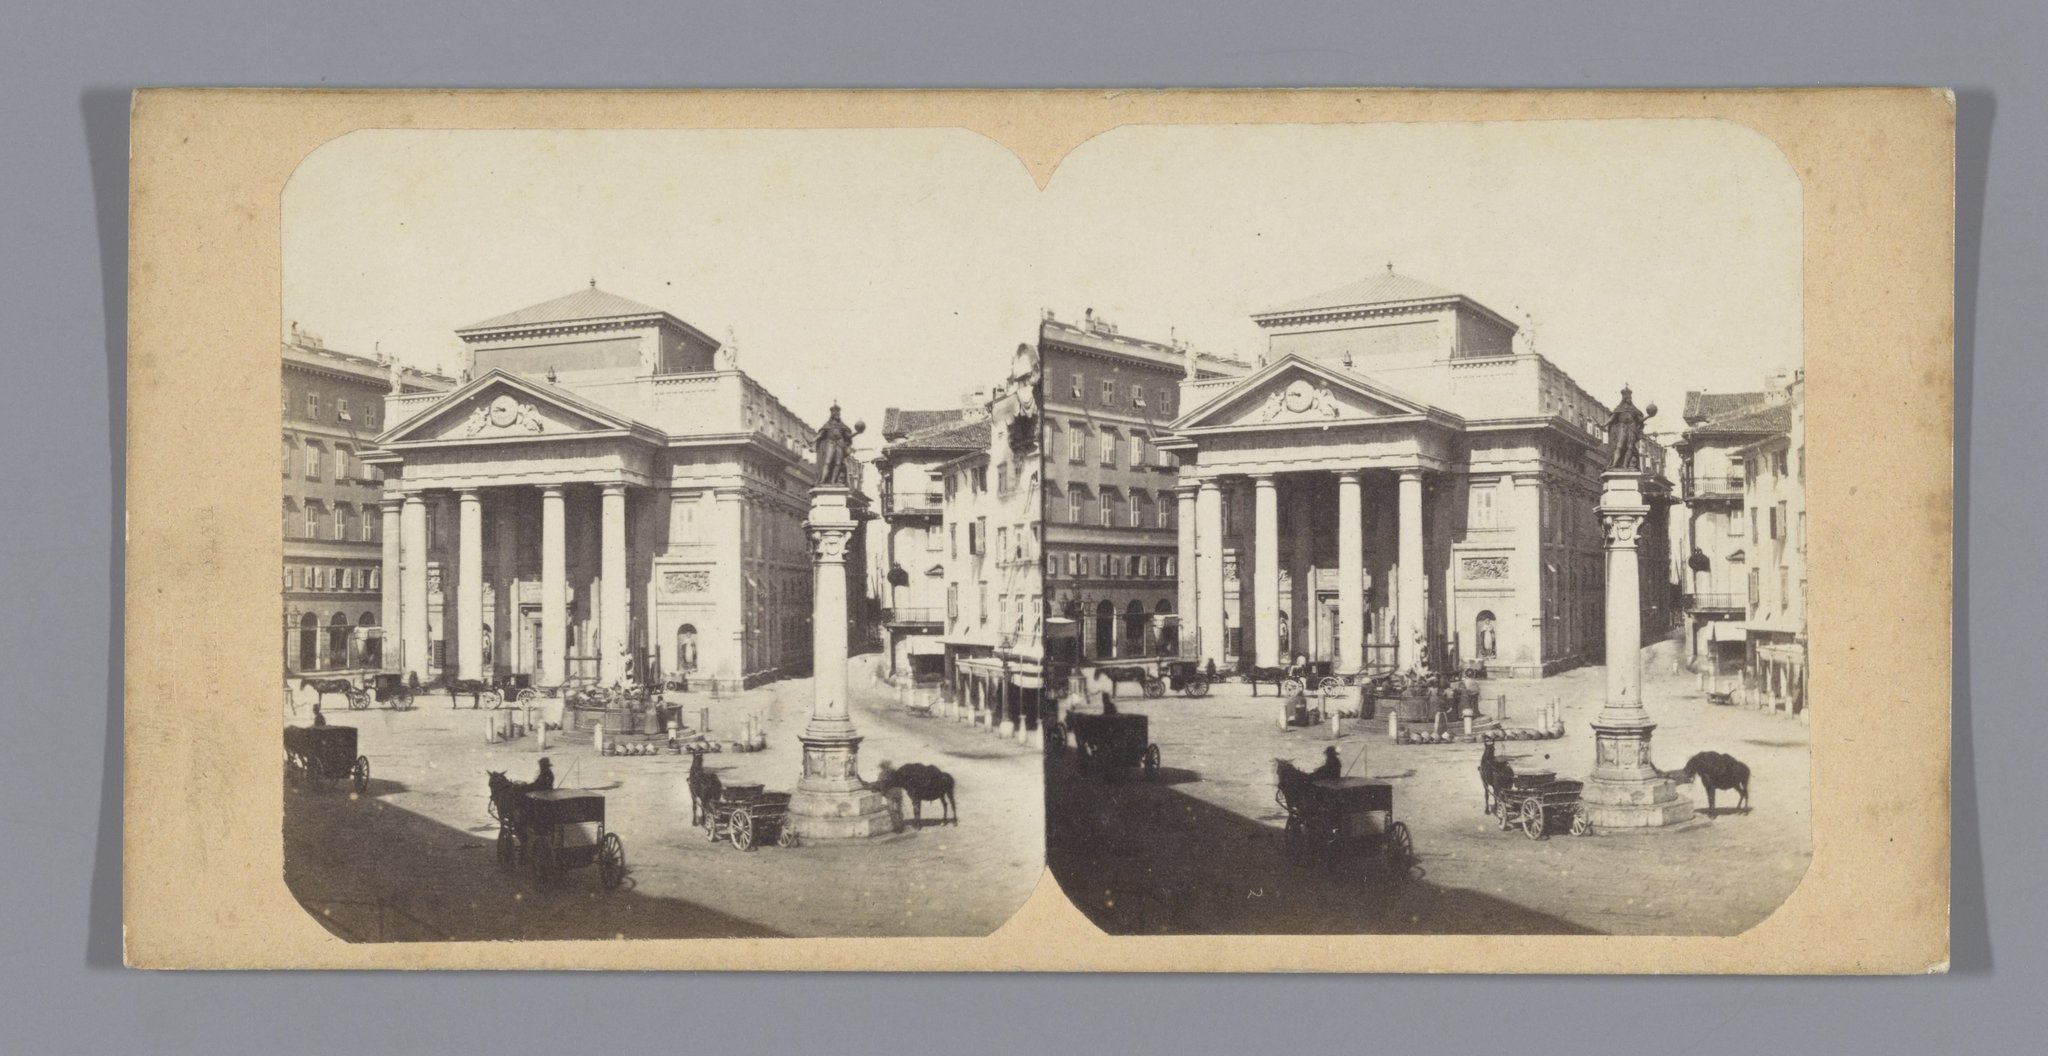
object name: stereograph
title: Gezicht op het Piazza della Borsa te Triëst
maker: Anonymous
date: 1850-1880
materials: cardboard, photographic support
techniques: albumen print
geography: piazza della borsa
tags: square, place, circus, etc., monument, statue, façade (of house or building)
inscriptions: number: ‘3.’